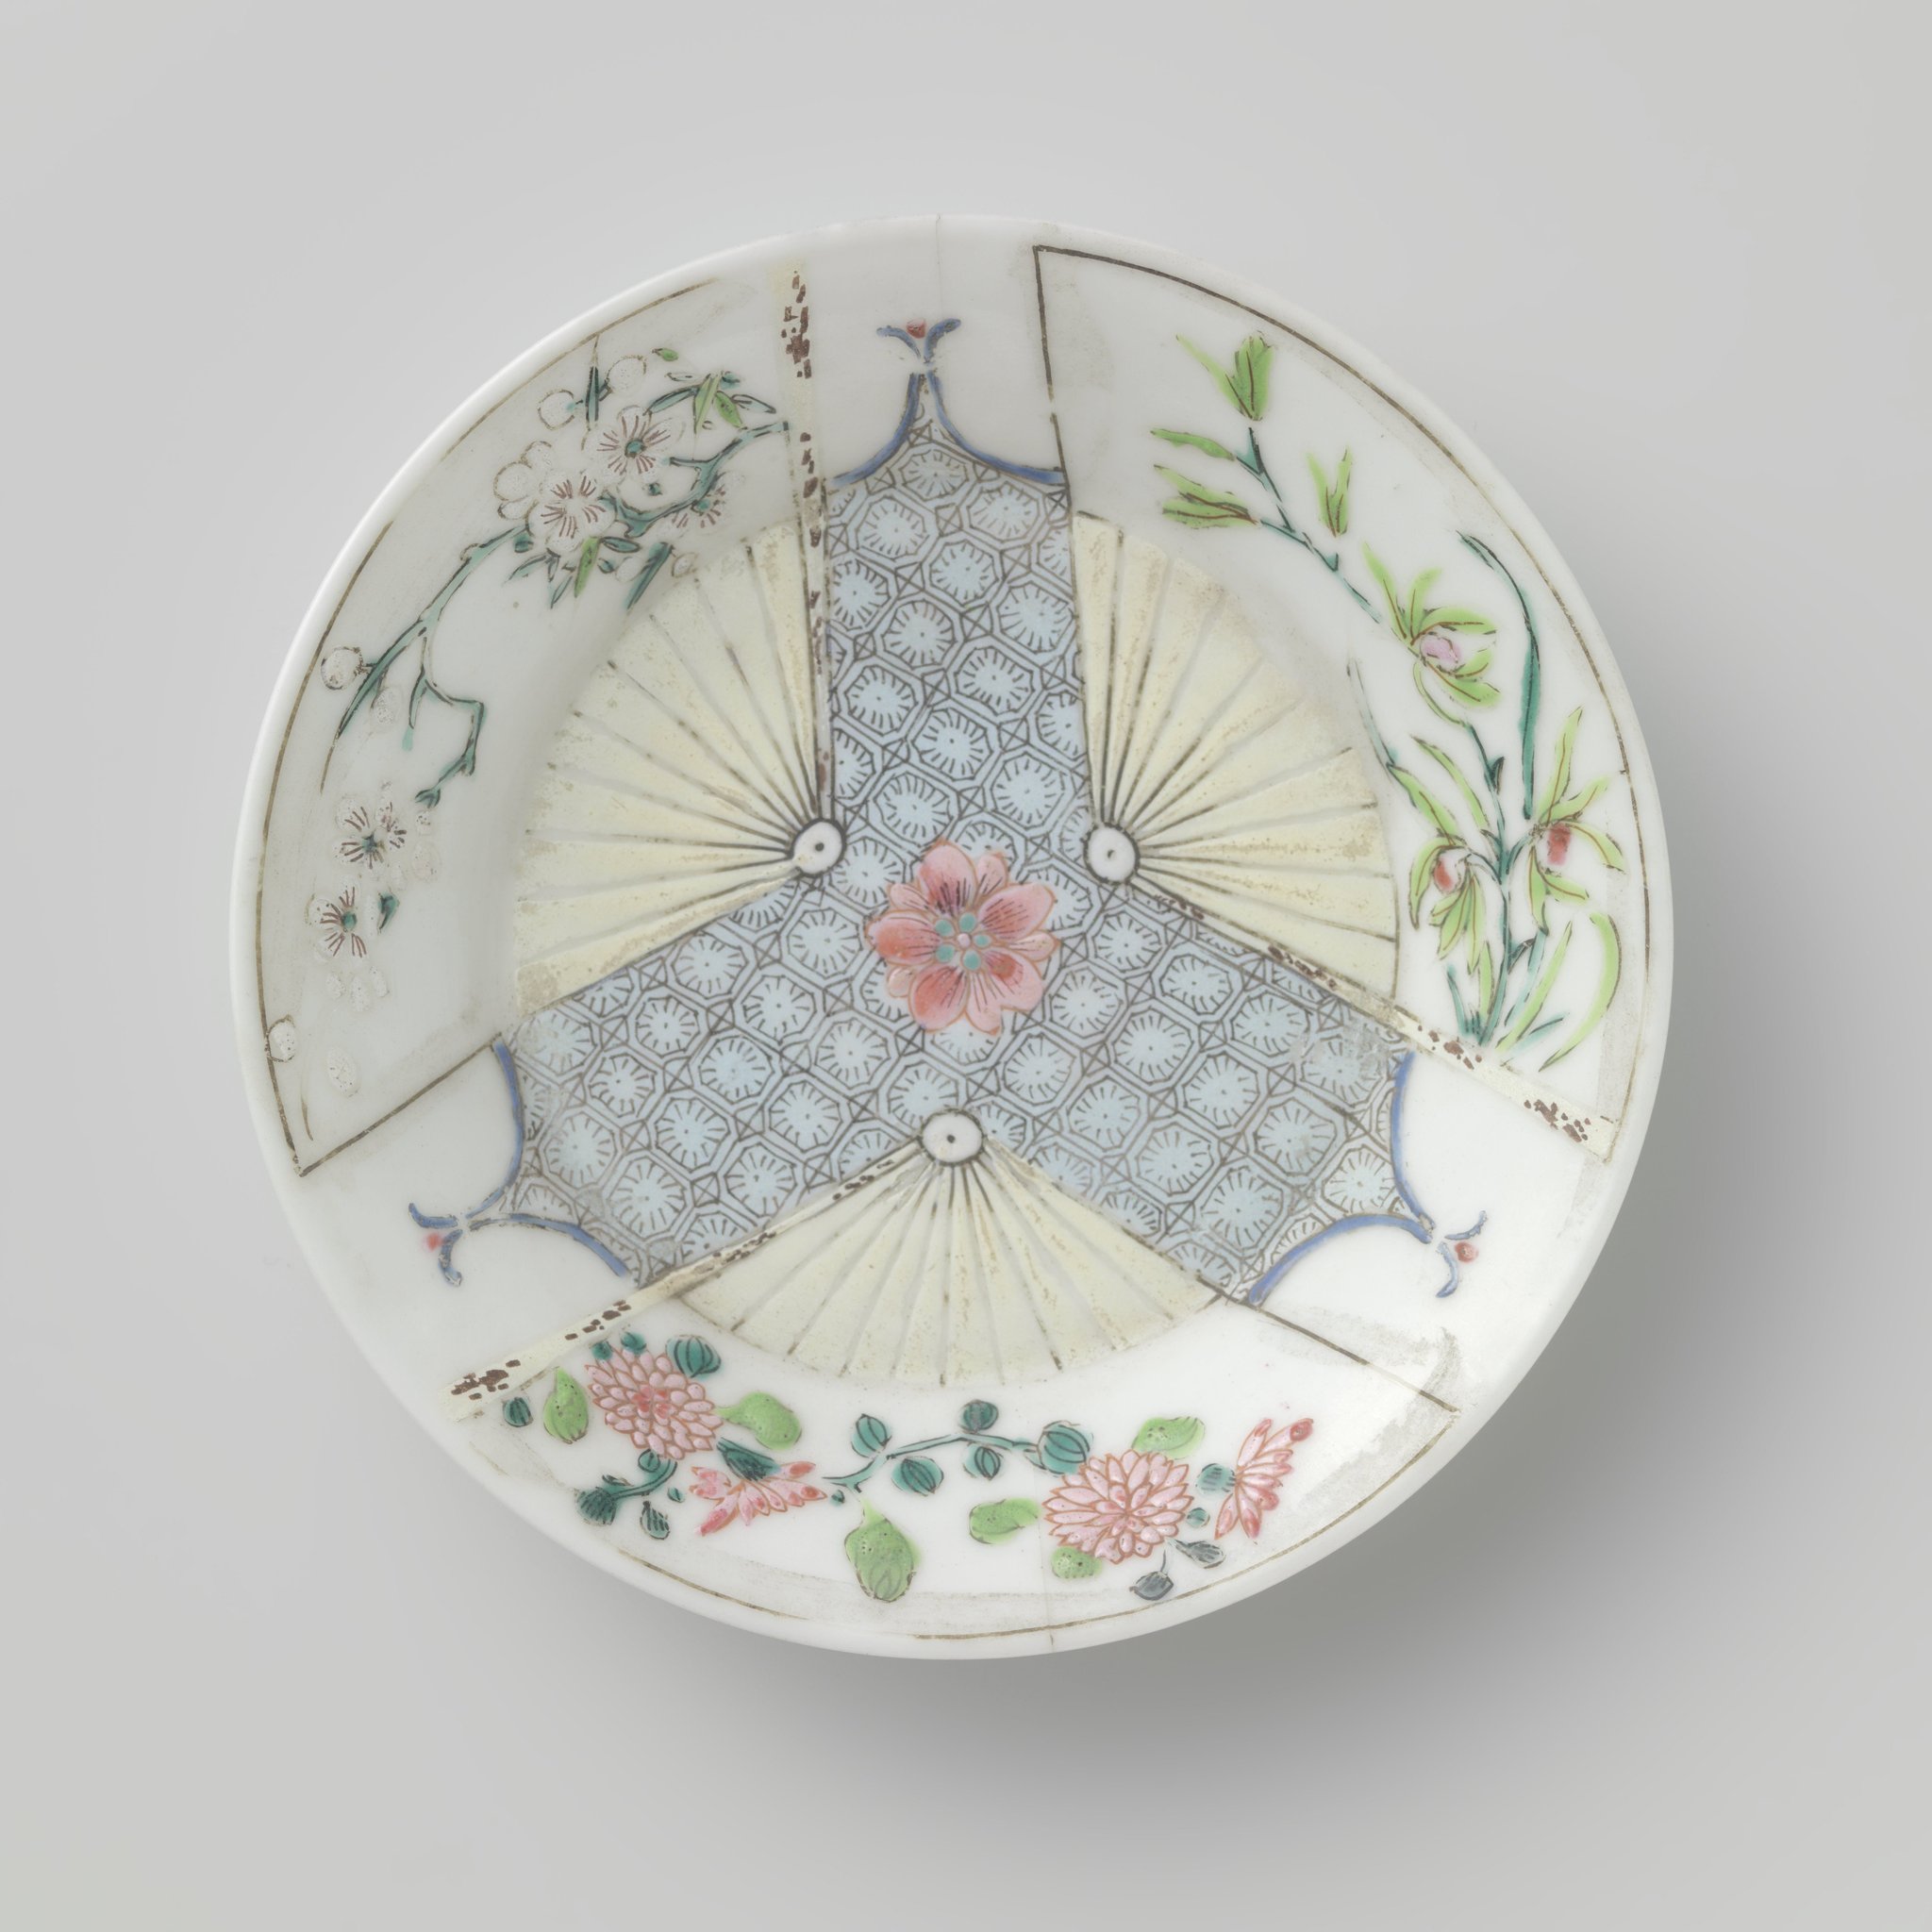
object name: platter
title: Saucer with three fans with flower sprays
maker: Anonymous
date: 1725-1749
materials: glaze, paint, porcelain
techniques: firing, turning, vitrification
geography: china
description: Kop en schotel, famille rose, met waaiers en bloemen op blauwe grond.